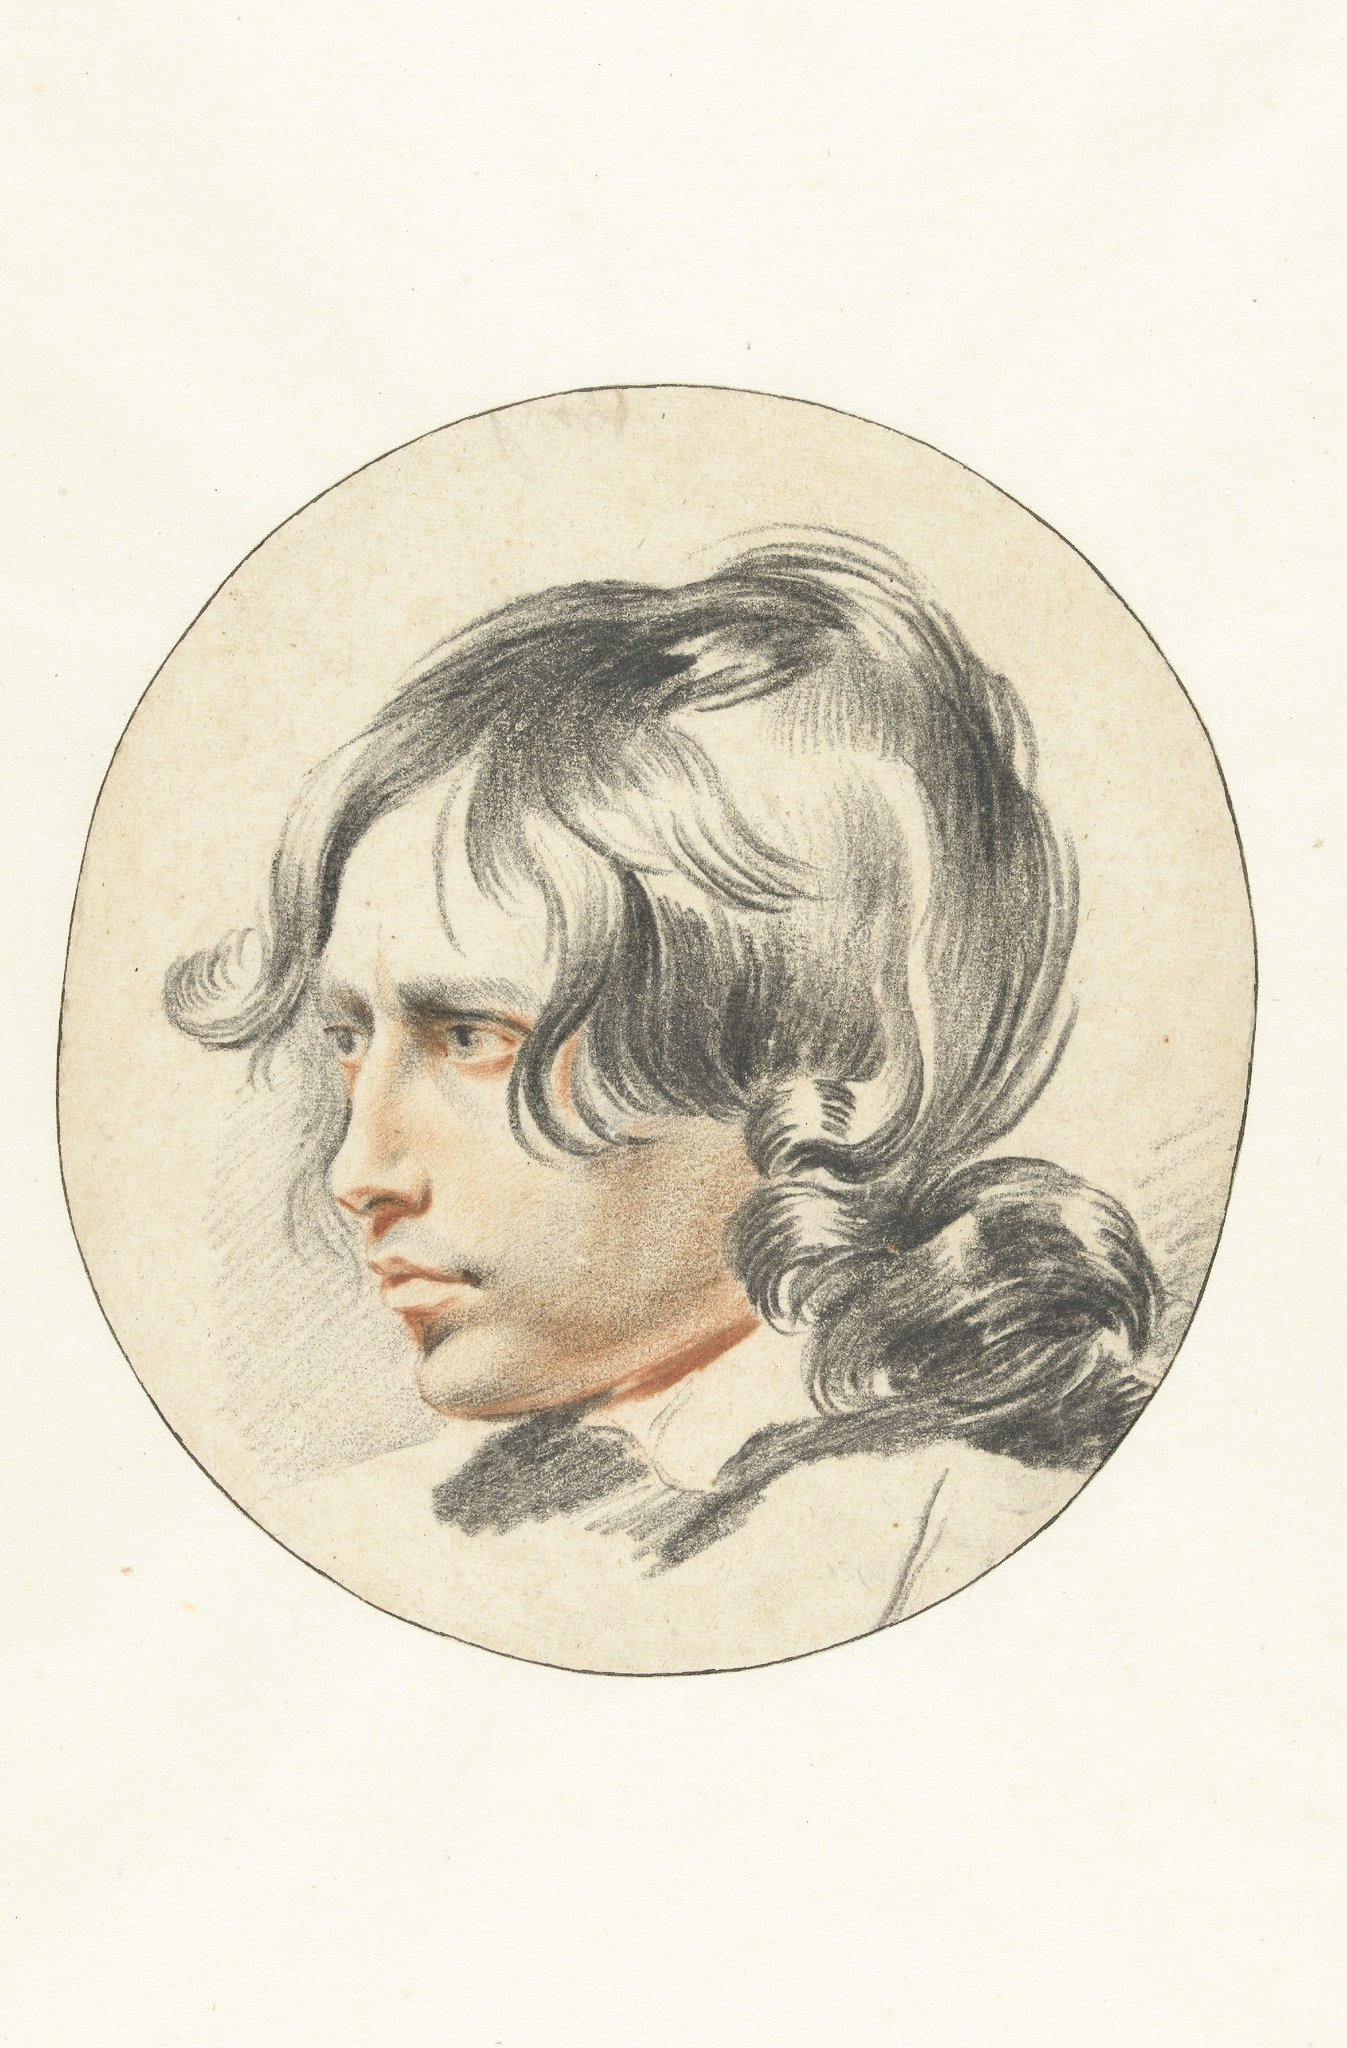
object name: drawing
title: Hoofd van een jongen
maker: leendert van der cooghen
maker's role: draughtsman, print maker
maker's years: 1632-1681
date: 1642-1681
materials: chalk, paper